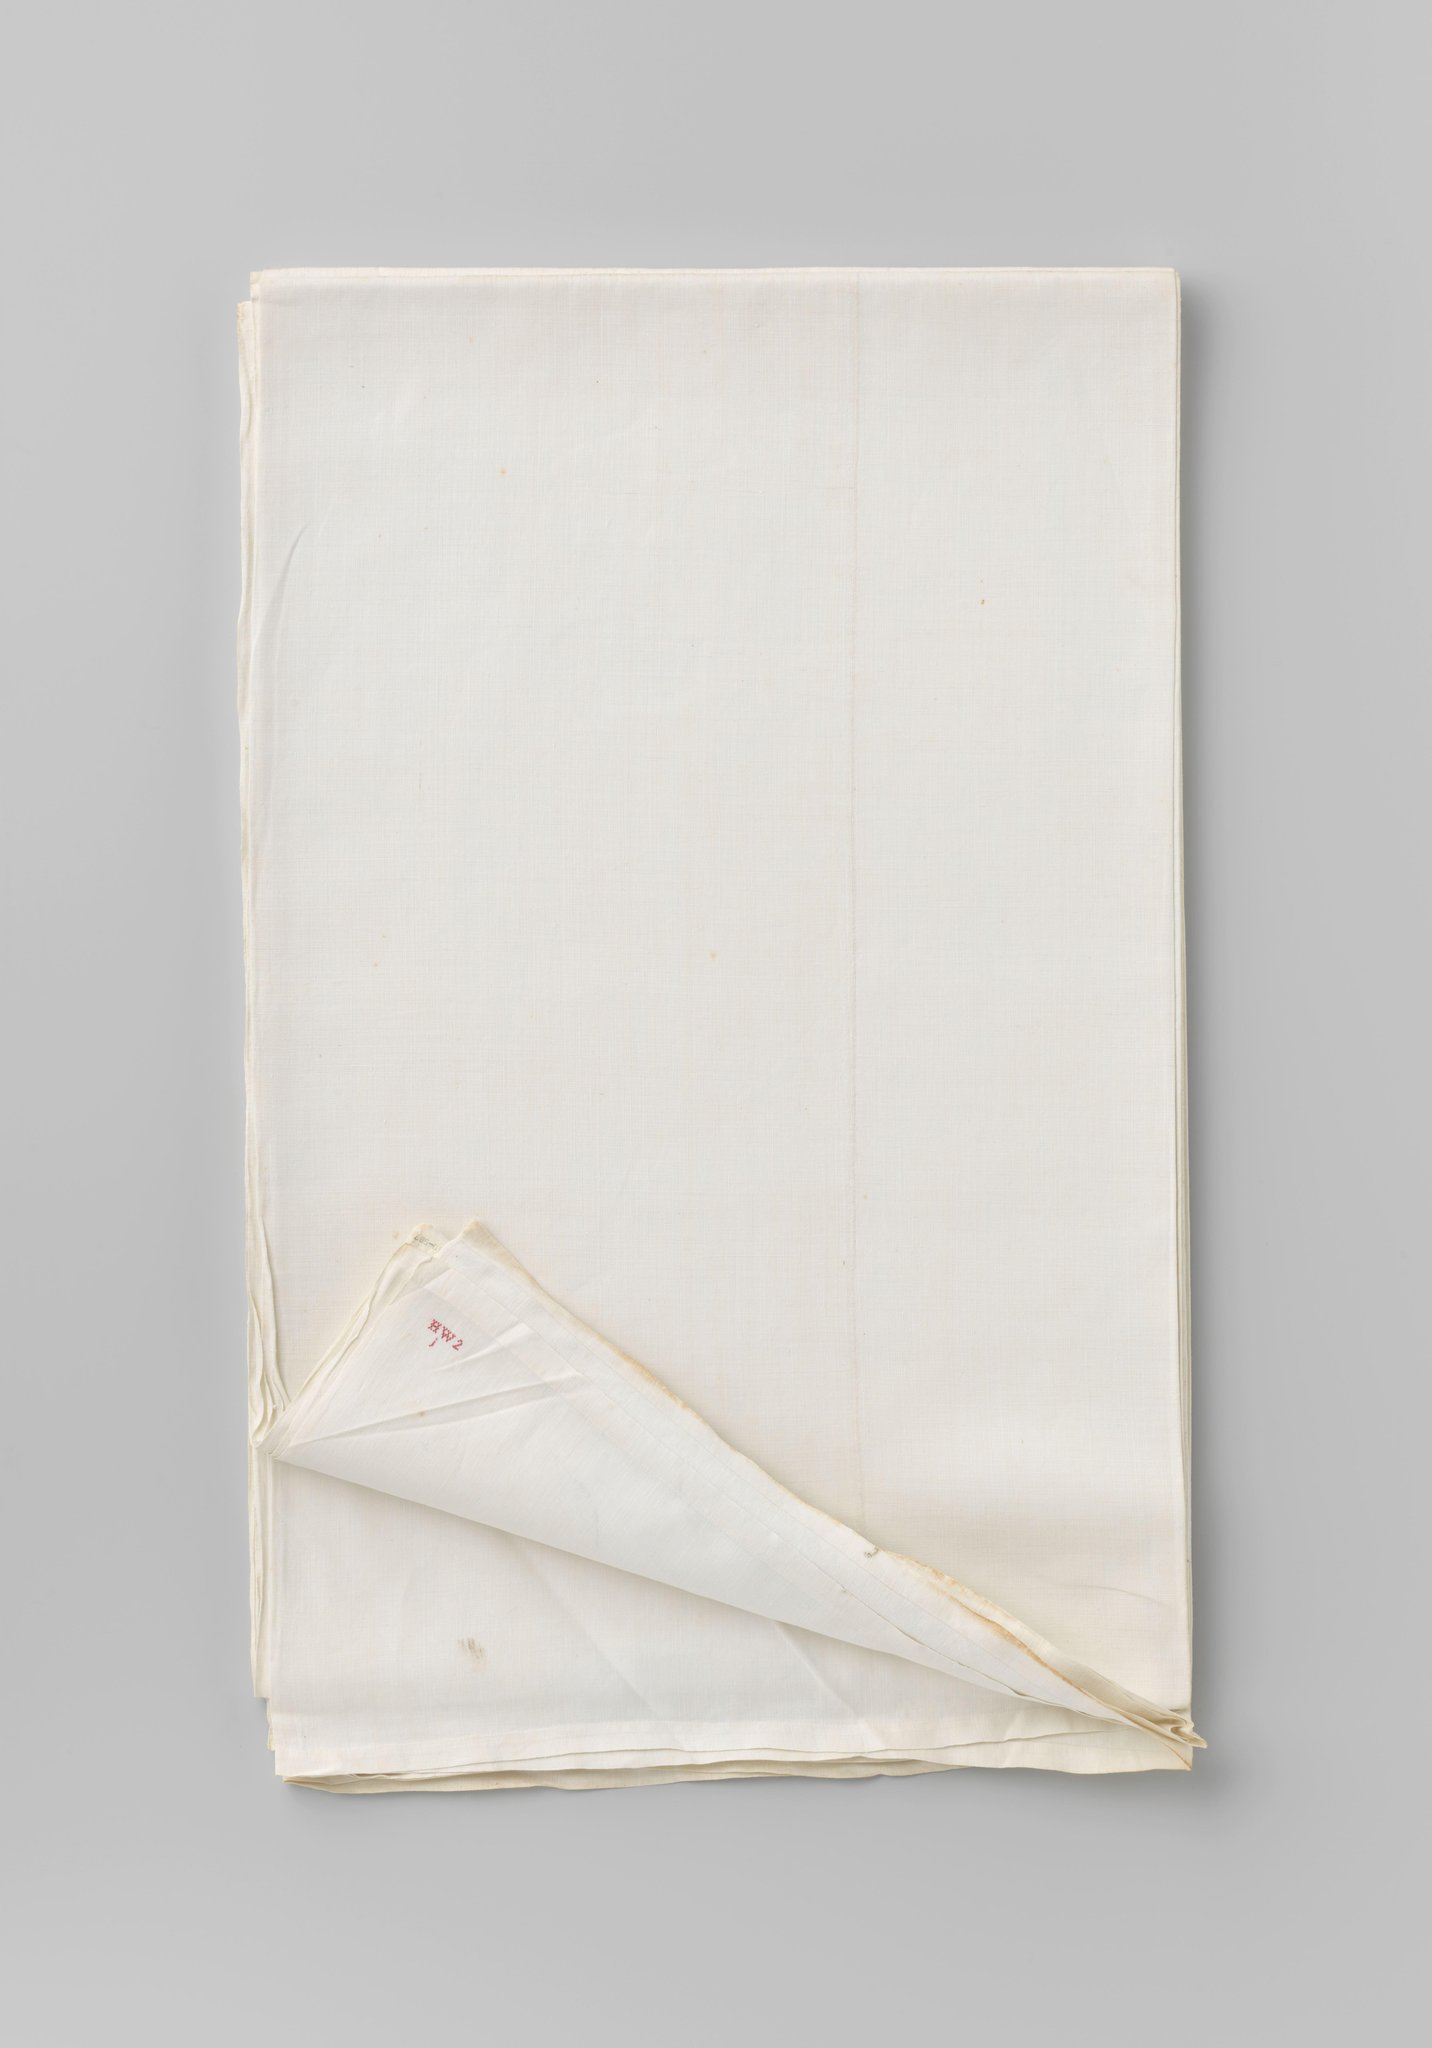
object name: beddenlaken, laken object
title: Laken. Merk: kroon IIVG en jaartal 1725, kroon WG3 HW12.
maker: Anonymous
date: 1725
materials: linen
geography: northern netherlands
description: Laken van wit linnen, merk kroon IIVG 1725 en kroon WG 3 HW 1 2